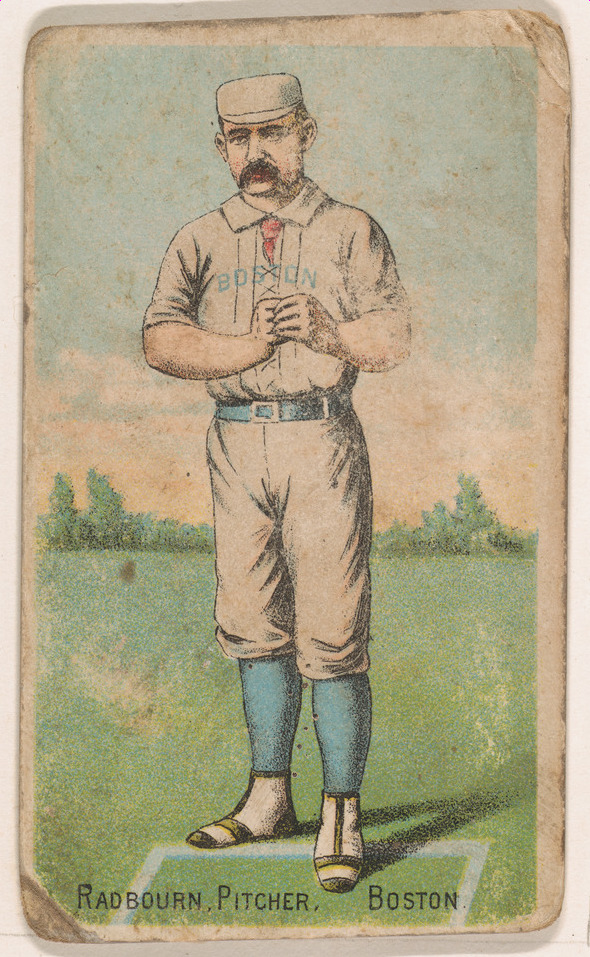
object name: baseball card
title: Radbourn, Pitcher, Boston, from the Gold Coin series (N284) for Gold Coin Chewing Tobacco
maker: d. buchner & co., new york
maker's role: publisher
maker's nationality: american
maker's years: 1850-1900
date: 1887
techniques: color lithograph, drawing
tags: men,portraits,baseball,athletes